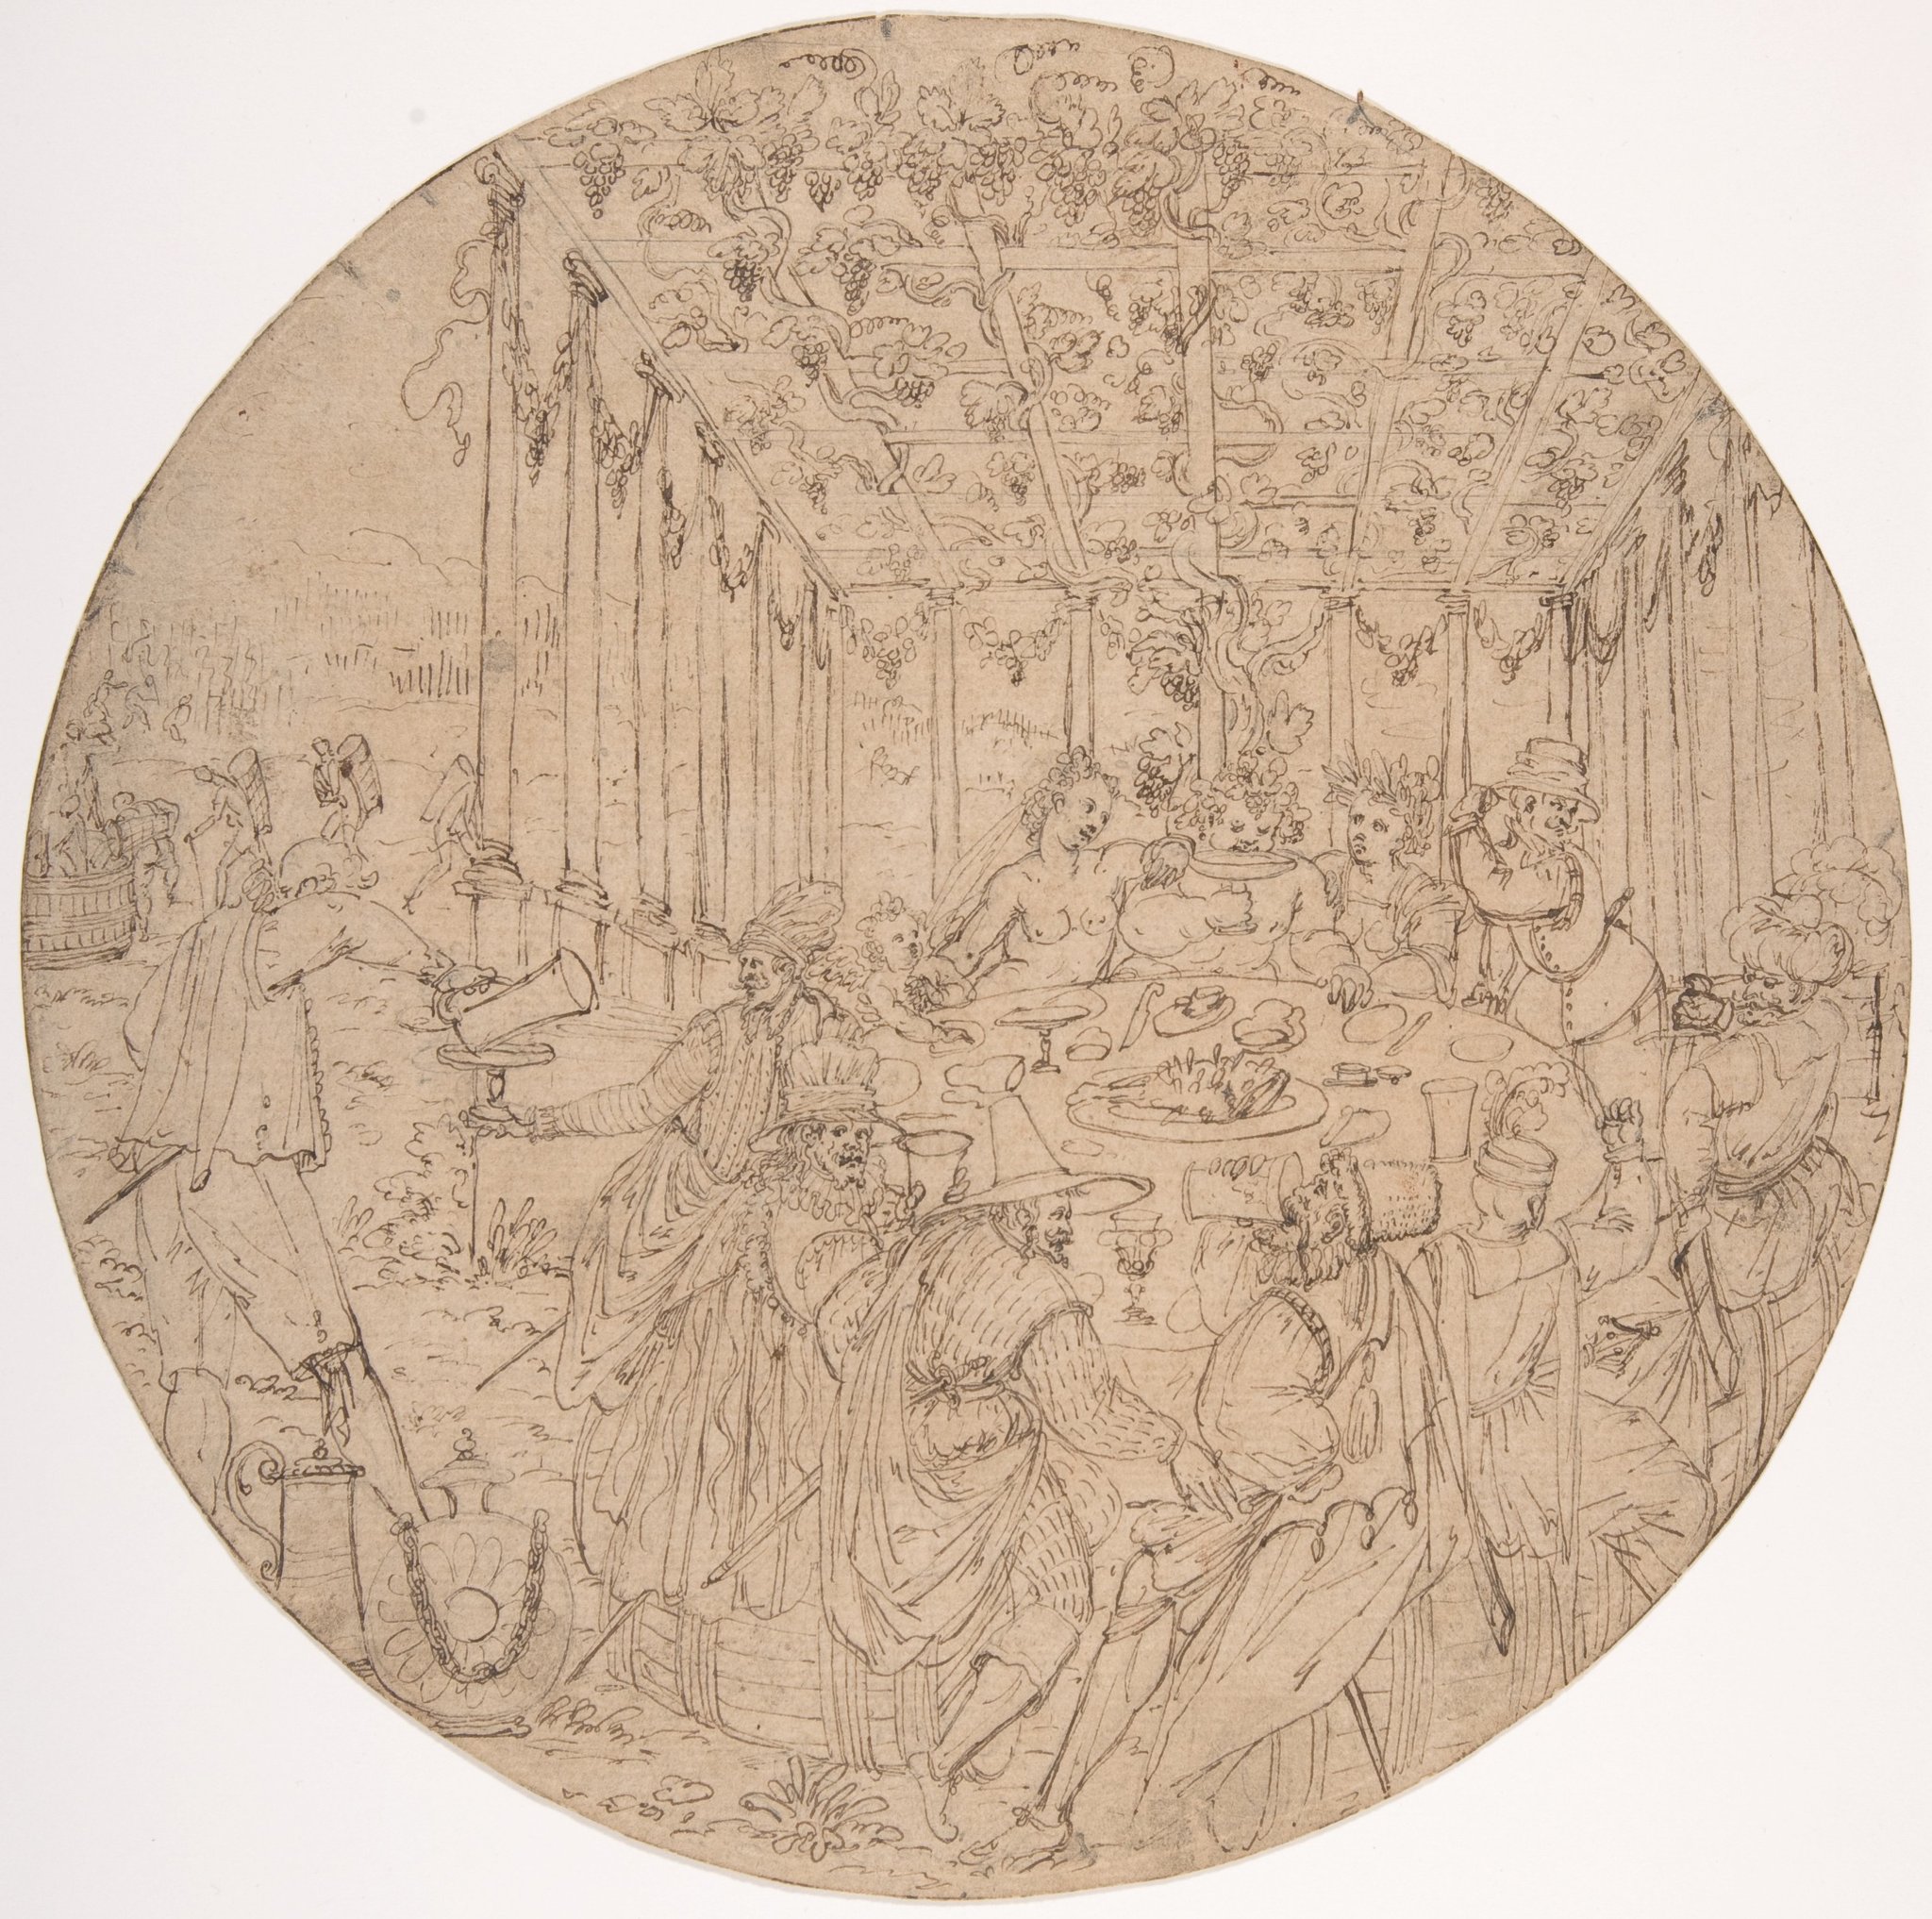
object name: drawing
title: Banquet in an Arbor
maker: anonymous, netherlandish, 16th century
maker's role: artist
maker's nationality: netherlandish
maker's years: 1500-1600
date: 1534-1633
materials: chalk, graphite, ink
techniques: incising, pen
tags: interiors,men,female nudes,party